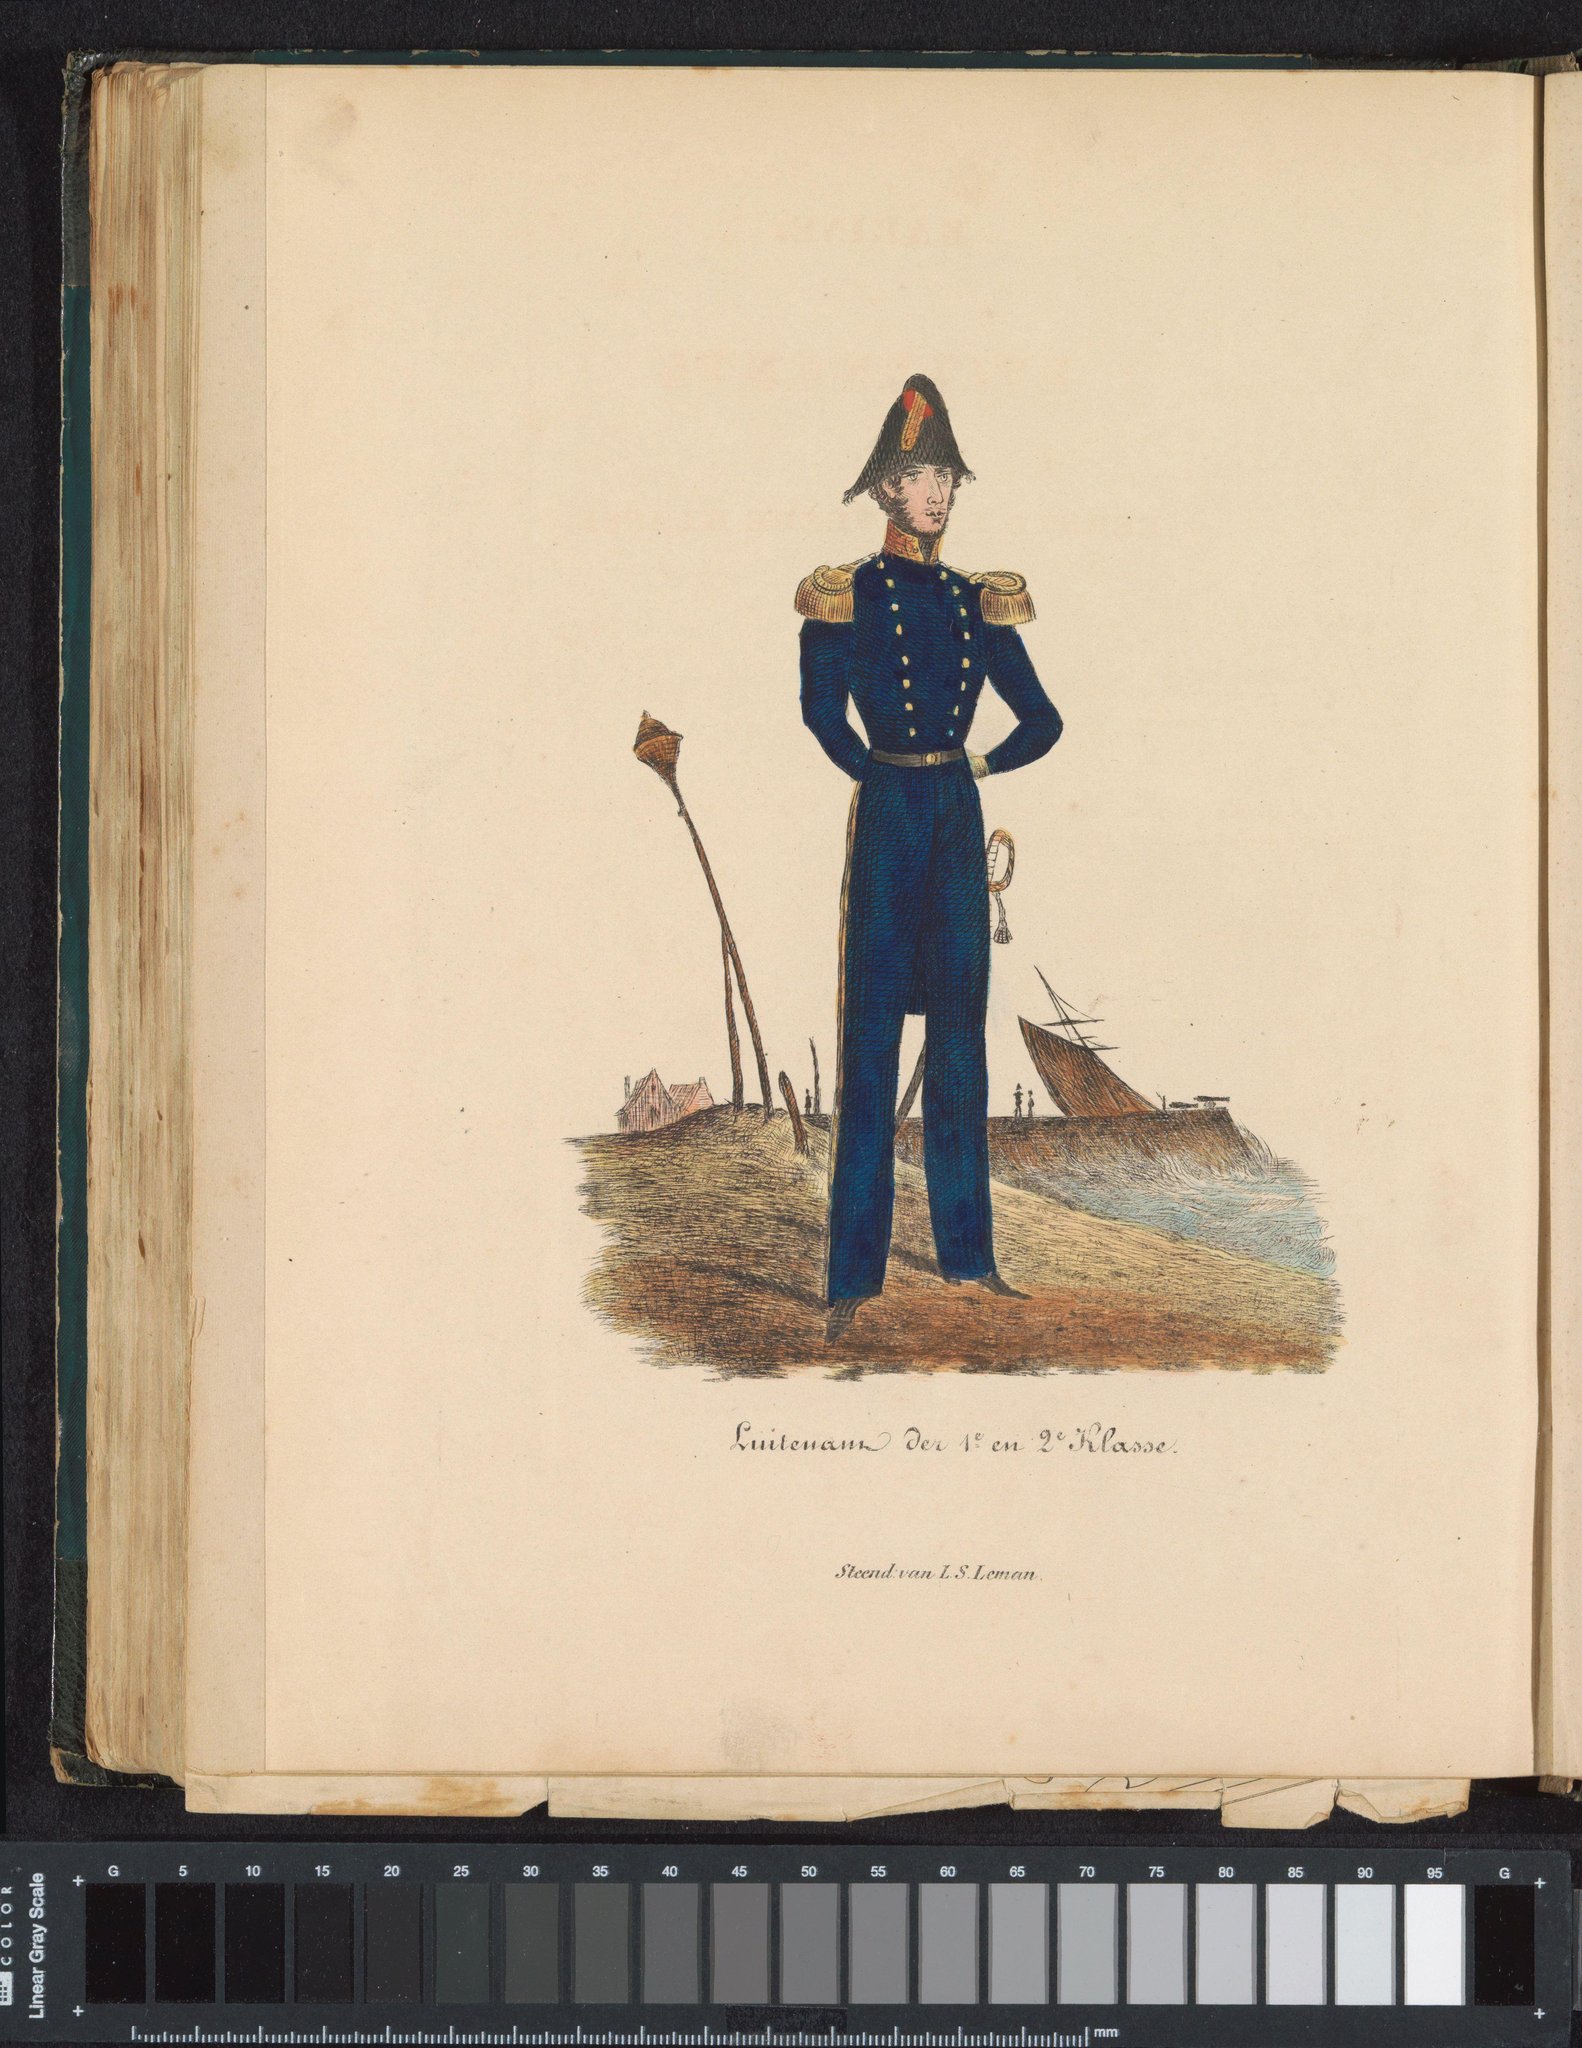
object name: costume print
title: Luitenant der 1e en 2e Klasse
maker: louis salomon leman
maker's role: steendrukker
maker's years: 1818-1889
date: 1845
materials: paper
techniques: hand coloring, lithograph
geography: amsterdam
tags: (military) uniforms, netherlands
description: Uniform voor de luitenants van de eerste en tweede klasse van de Marine. Illustratie in een boek uit 1845 over de uniformen en kledingstukken van de Nederlandse land-, zeemacht en schutterijen in Nederland en in de overzeese gebiedsdelen.